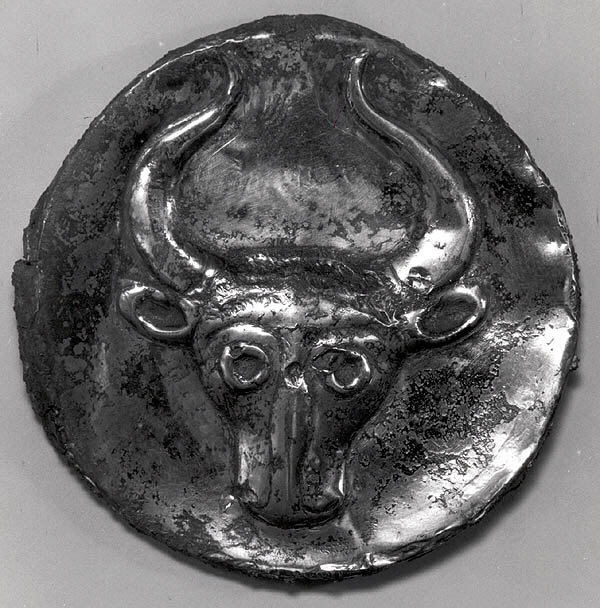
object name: relief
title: Plaque or lid with a bull's head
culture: bactria-margiana archaeological complex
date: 2333-1668 BCE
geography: bactria-margiana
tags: bulls